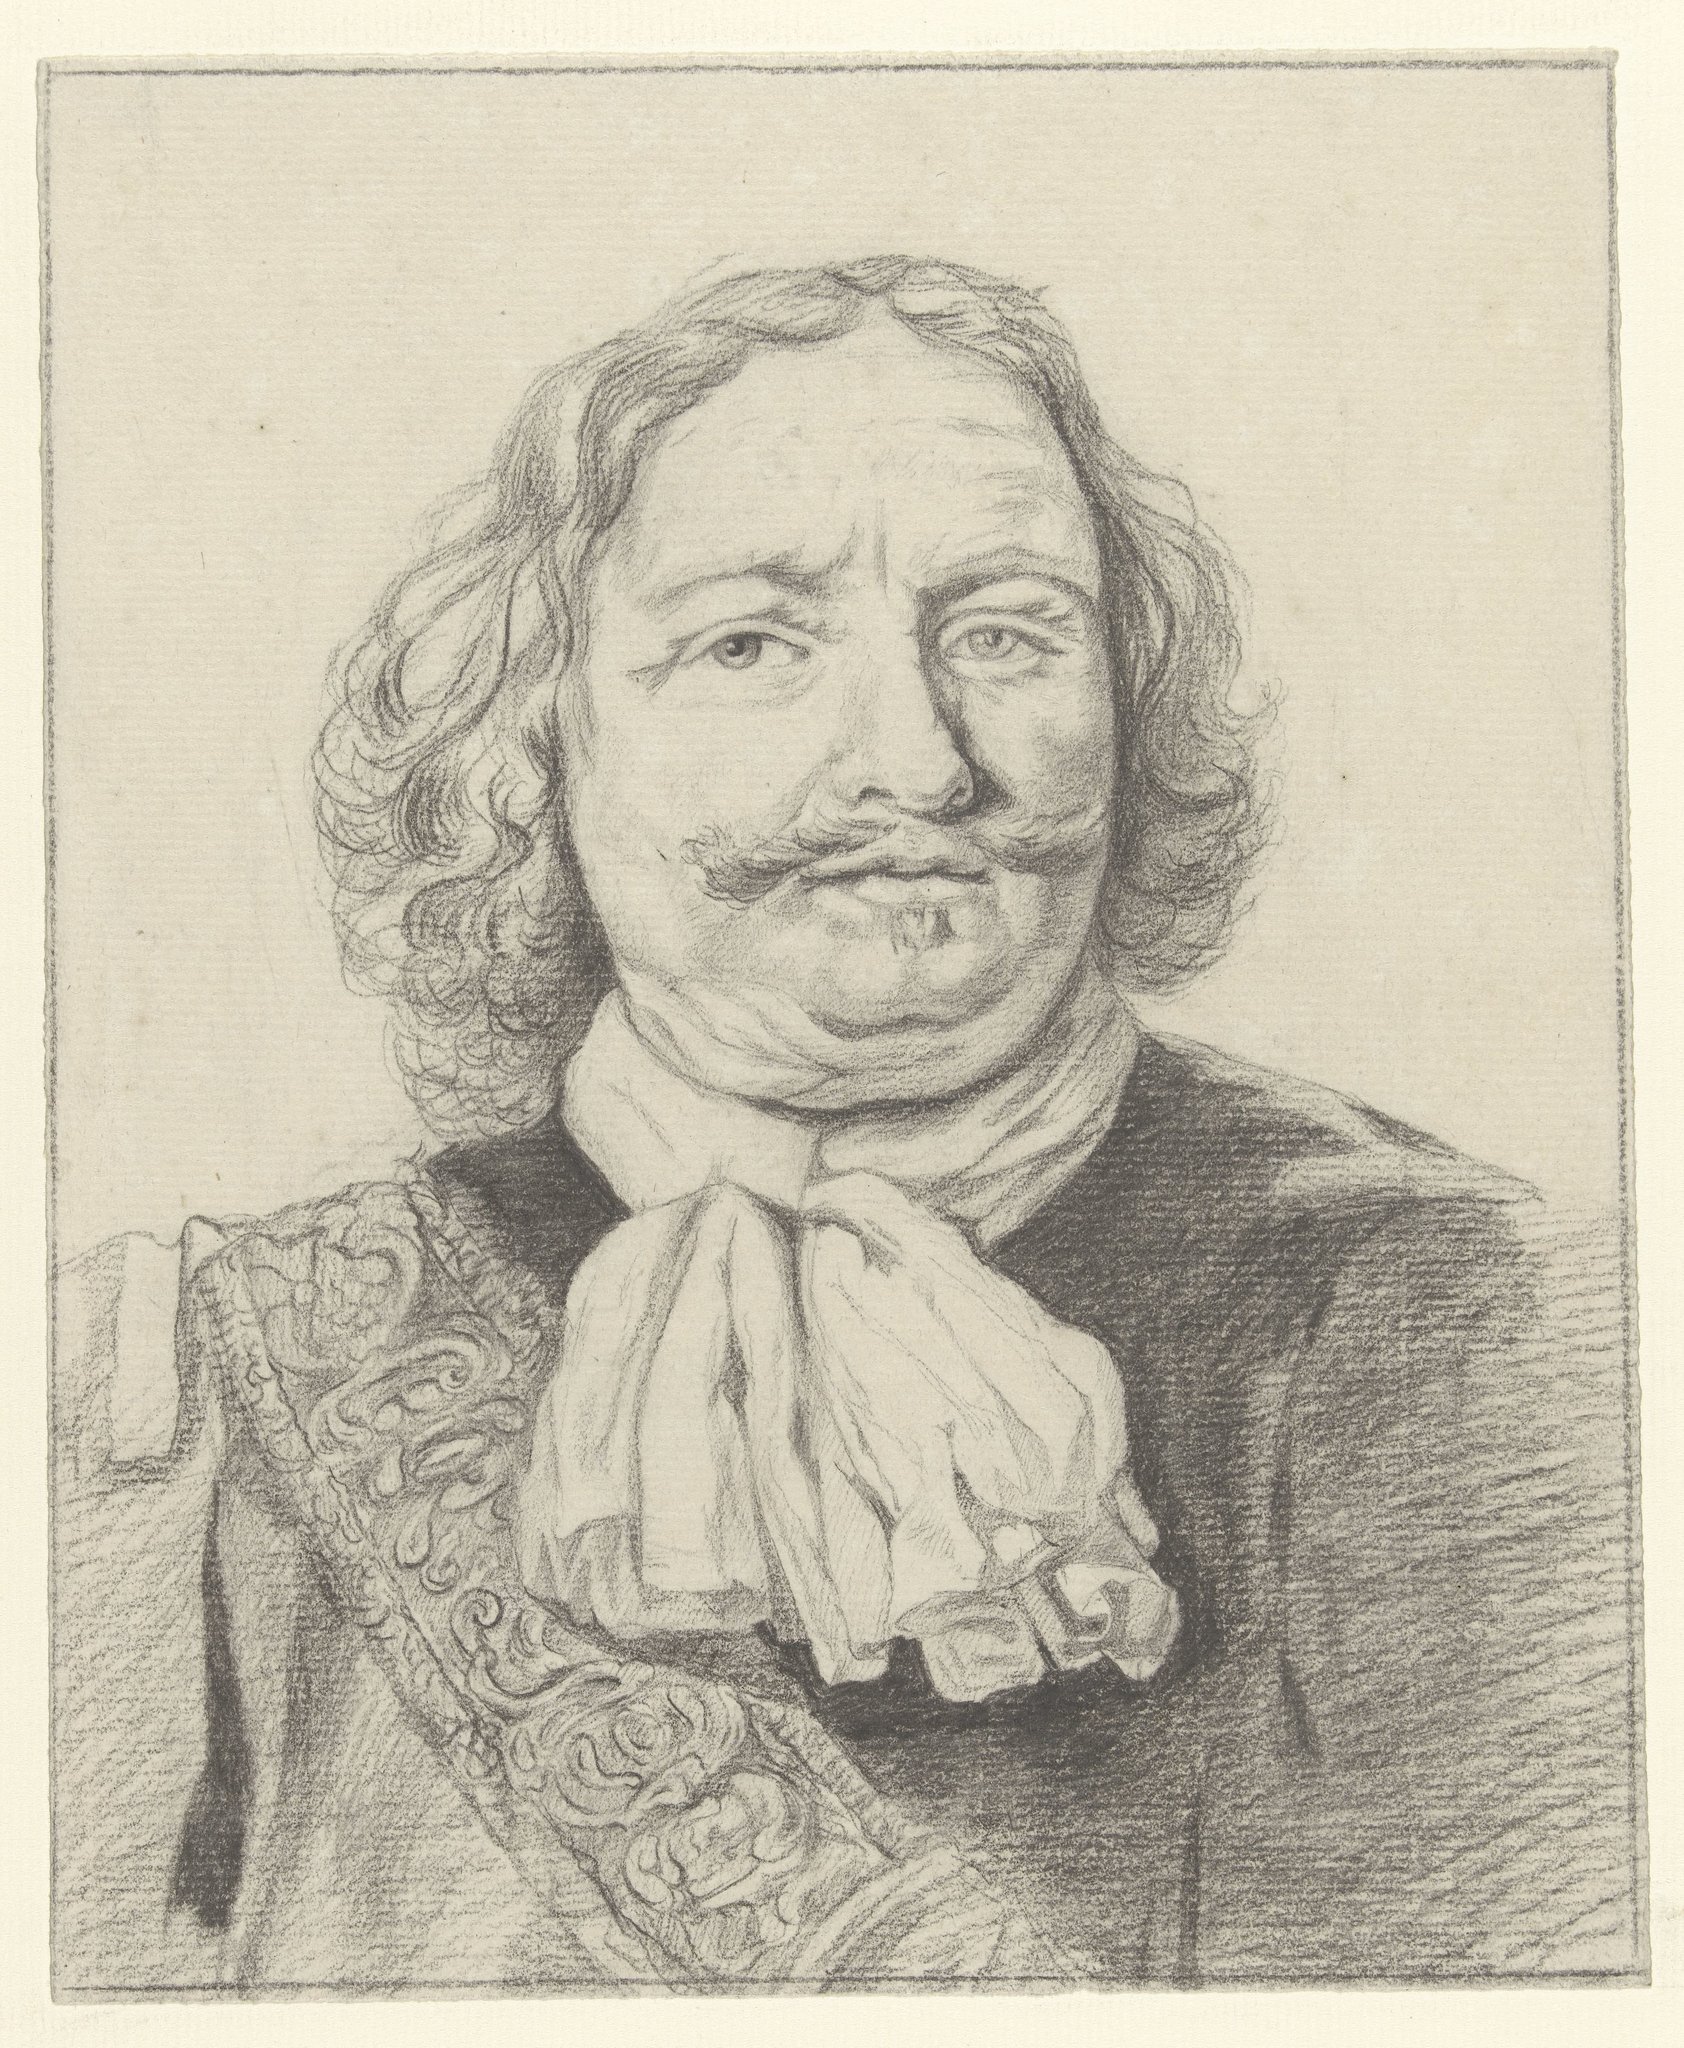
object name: drawing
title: Portret van Egbert Meeusz Kortenaer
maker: albertus brondgeest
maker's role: draughtsman, print maker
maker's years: 1786-1849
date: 1796-1849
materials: chalk, paper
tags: historical persons